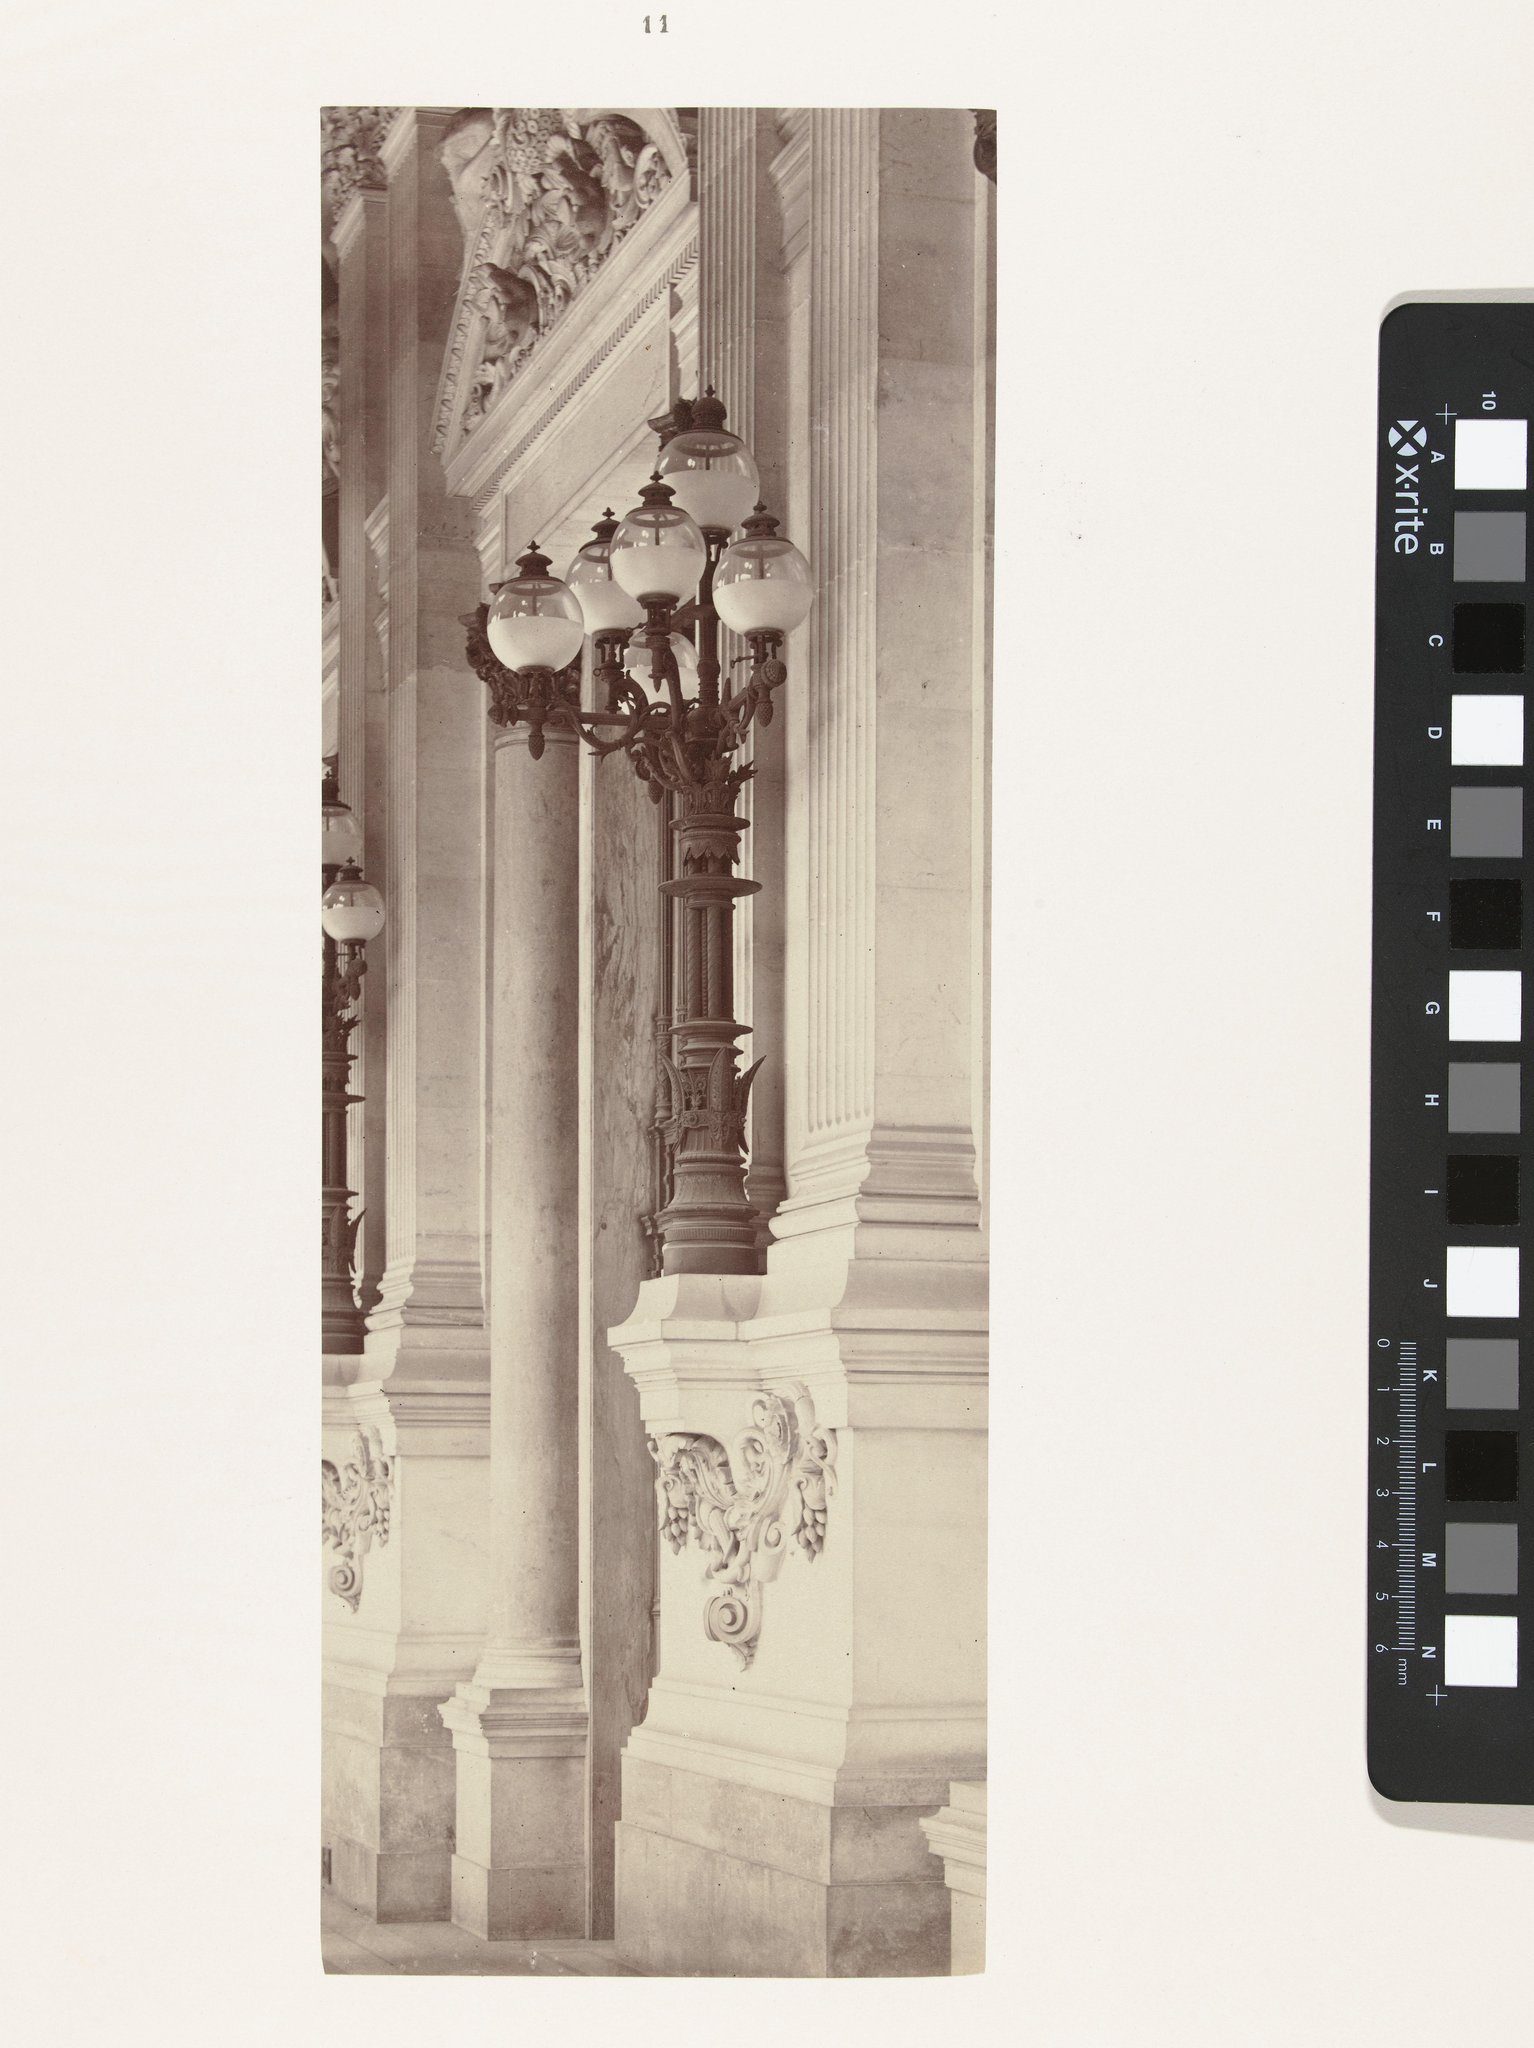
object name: photograph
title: 11. Le nouvel Opéra de Paris. Bronzes.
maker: louis-emile durandelle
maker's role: fotograaf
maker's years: 1839-1917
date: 1878-1881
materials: photographic support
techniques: albumen print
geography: paris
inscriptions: number: ‘11’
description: bij boek in Bibliotheek RMA, Zie Frizot, pp. 217-223, vgl G. Vicaire, Manuel de l'amateur de livres du XIXe siècle, vol. 3, column 870.